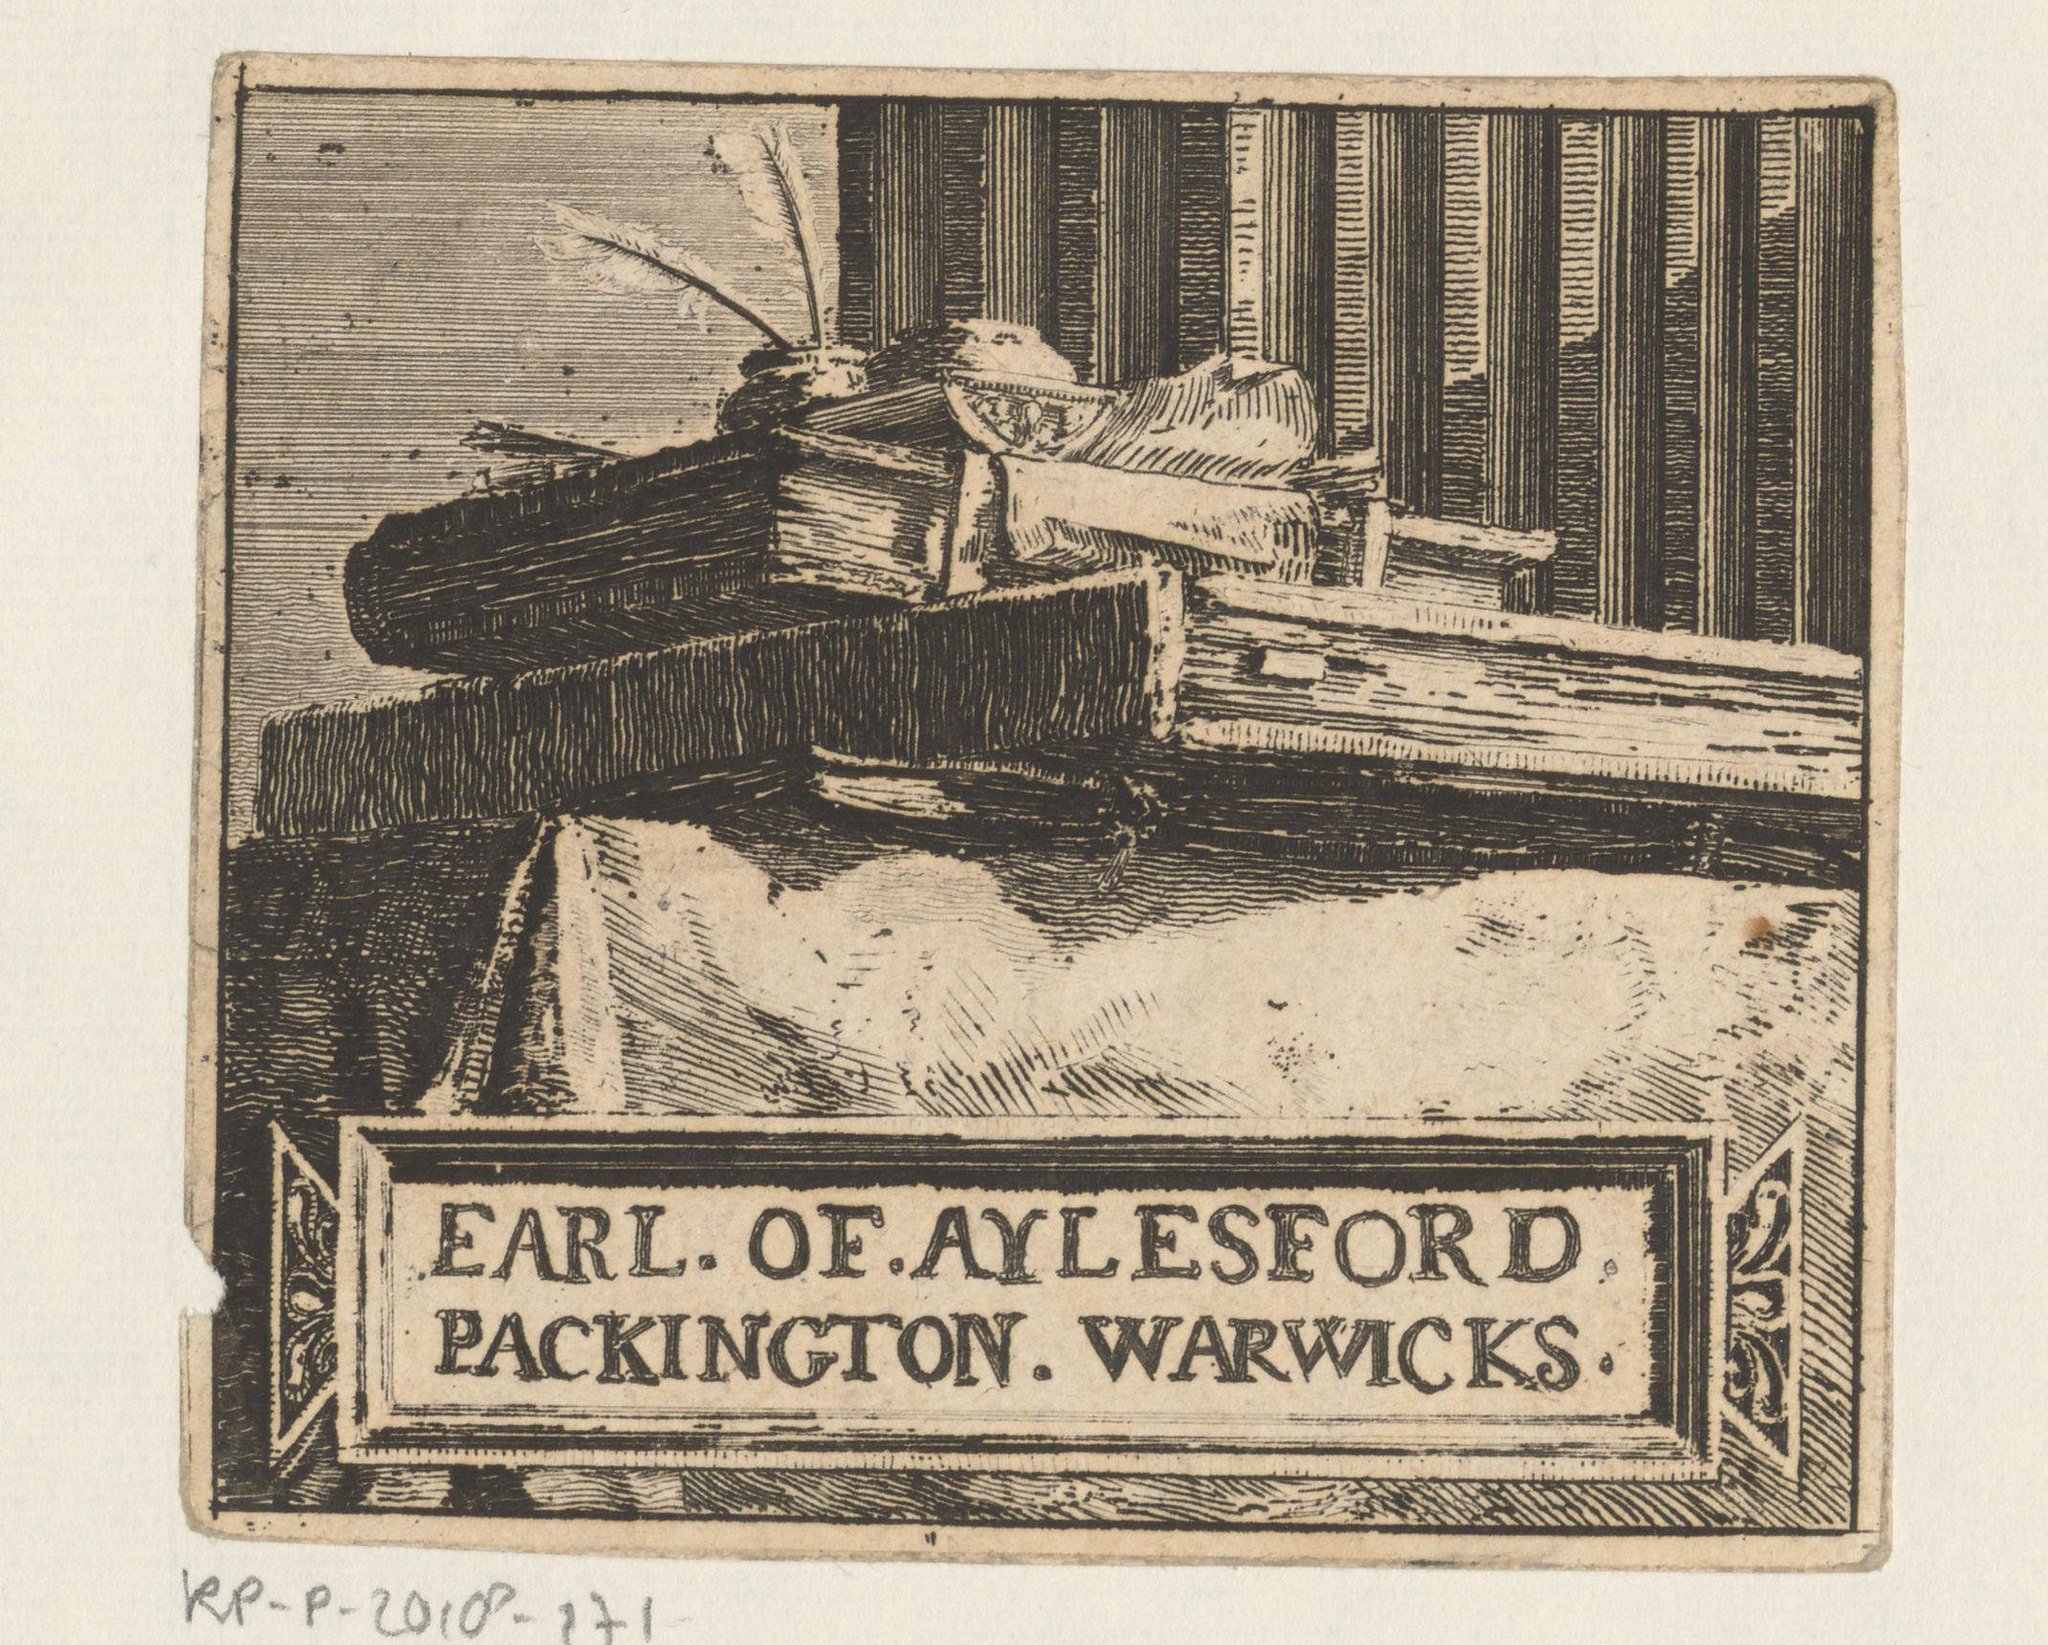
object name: bookplate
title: Earl of Aylesford/ Packington. Warwicks.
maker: heneage finch (vierde graaf aylesford)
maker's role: print maker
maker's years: 1751-1812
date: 1780-1789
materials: paper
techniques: etching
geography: england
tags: print maker, heneage finch (vierde graaf aylesford), castle, arms, armour